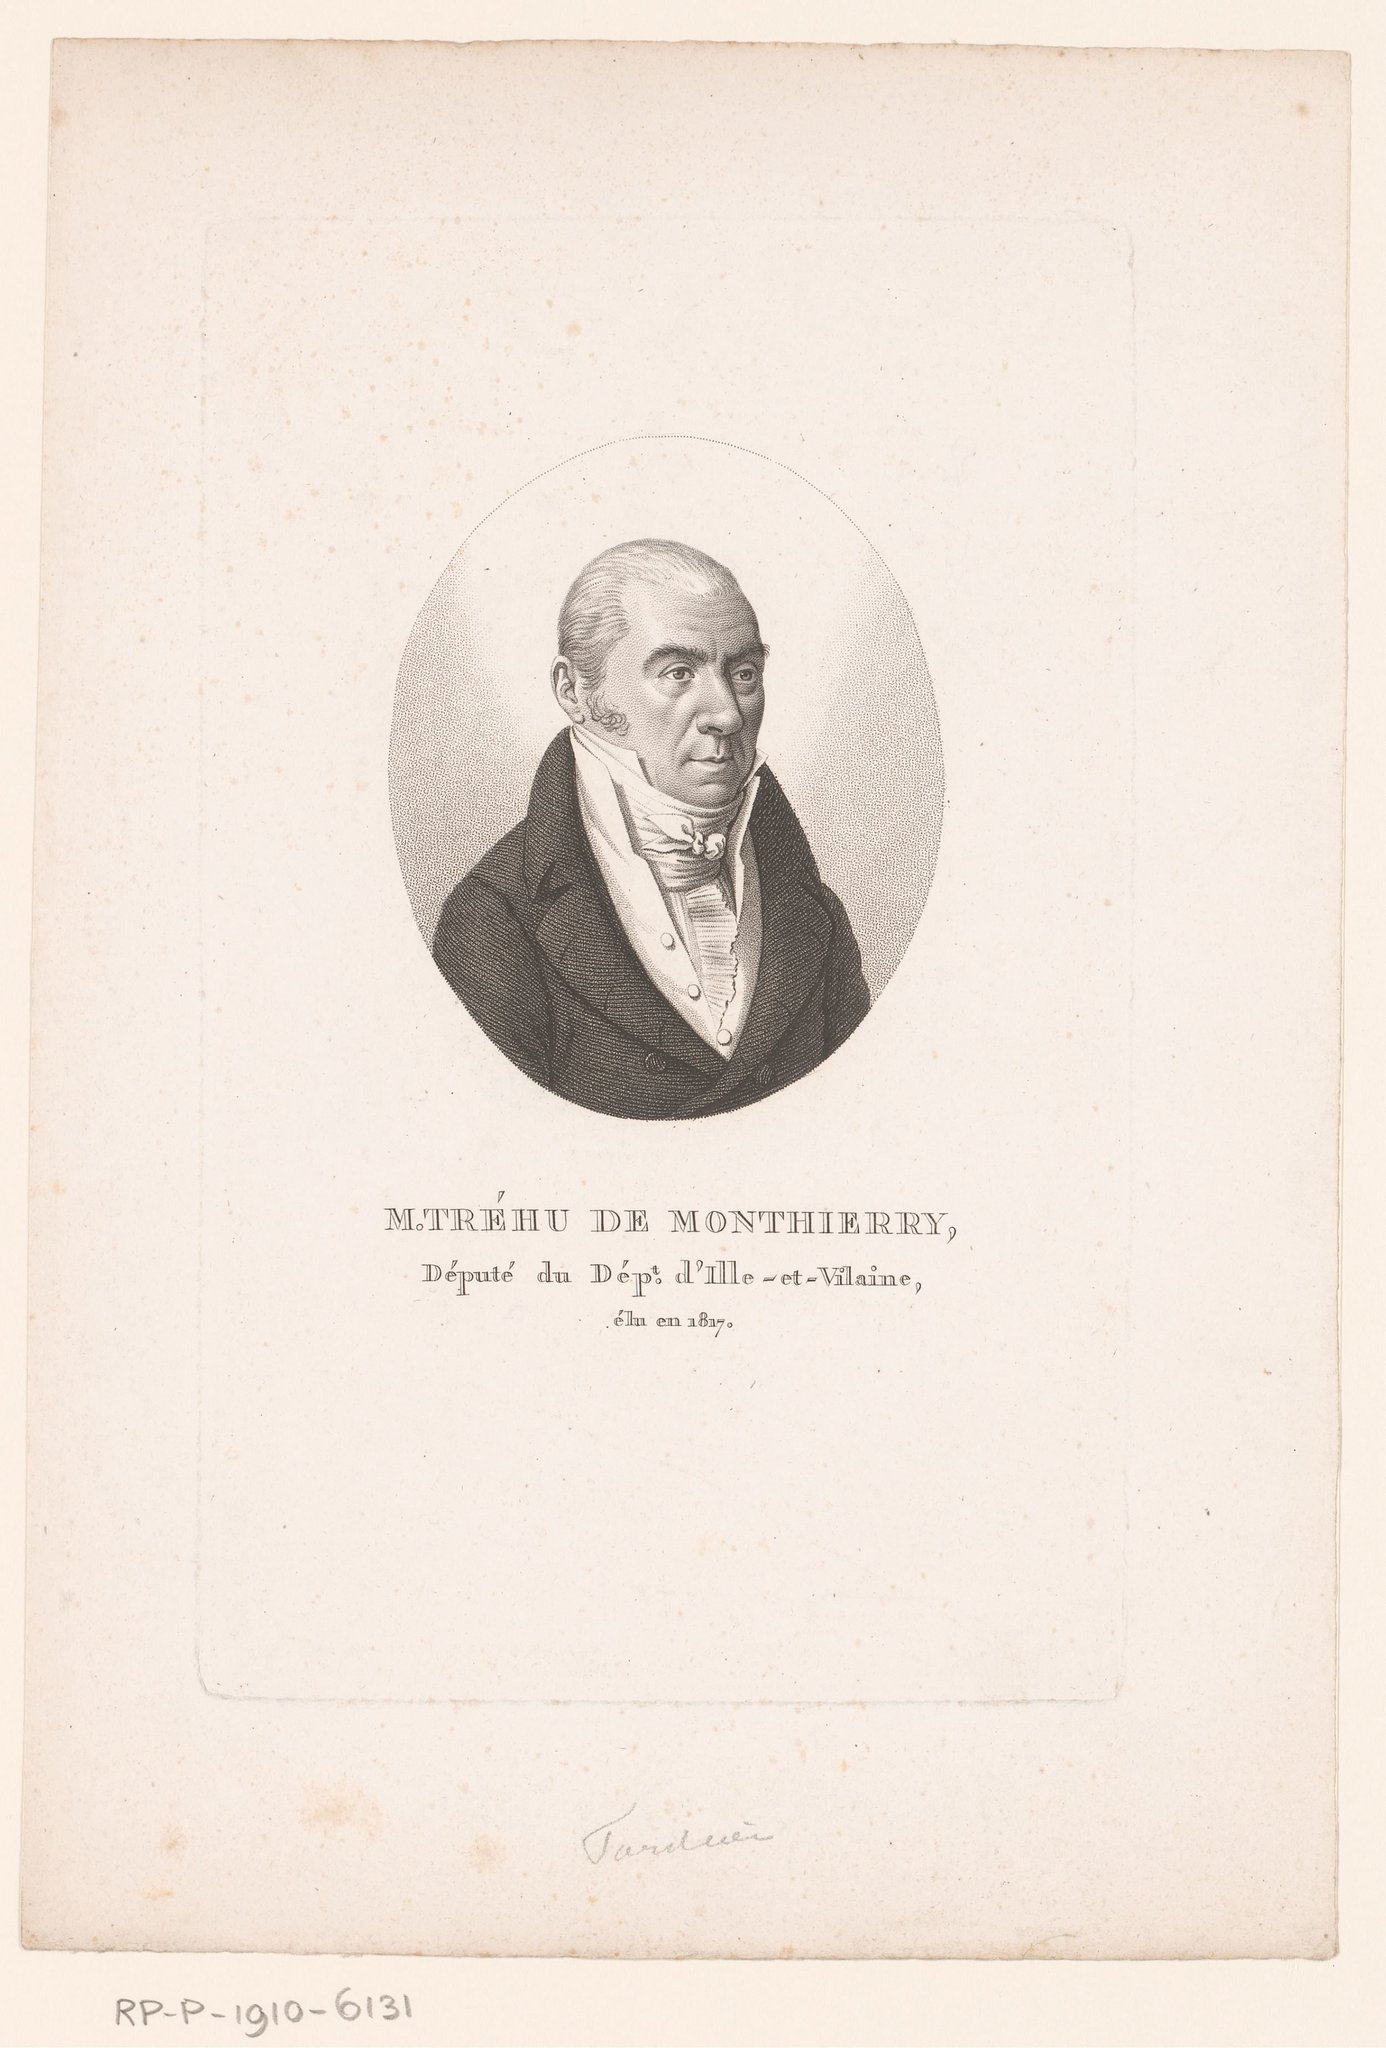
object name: book illustration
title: Portret van Julien Tréhu de Monthierry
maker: ambroise tardieu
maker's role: print maker, printer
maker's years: 1788-1841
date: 1820-1821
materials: paper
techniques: engraving, roulette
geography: paris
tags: politician, historical persons, politician, e.g. party leader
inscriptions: collector's mark: Lugt 2228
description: Prent uit: Tardieu, Ambroise. Portraits des députés, écrivains et pairs constitutionnels, défenseurs invariables de la charte et de la loi des élections du 5 février 1817. Parijs: Tardieu, Ambroise, 1820-1821.